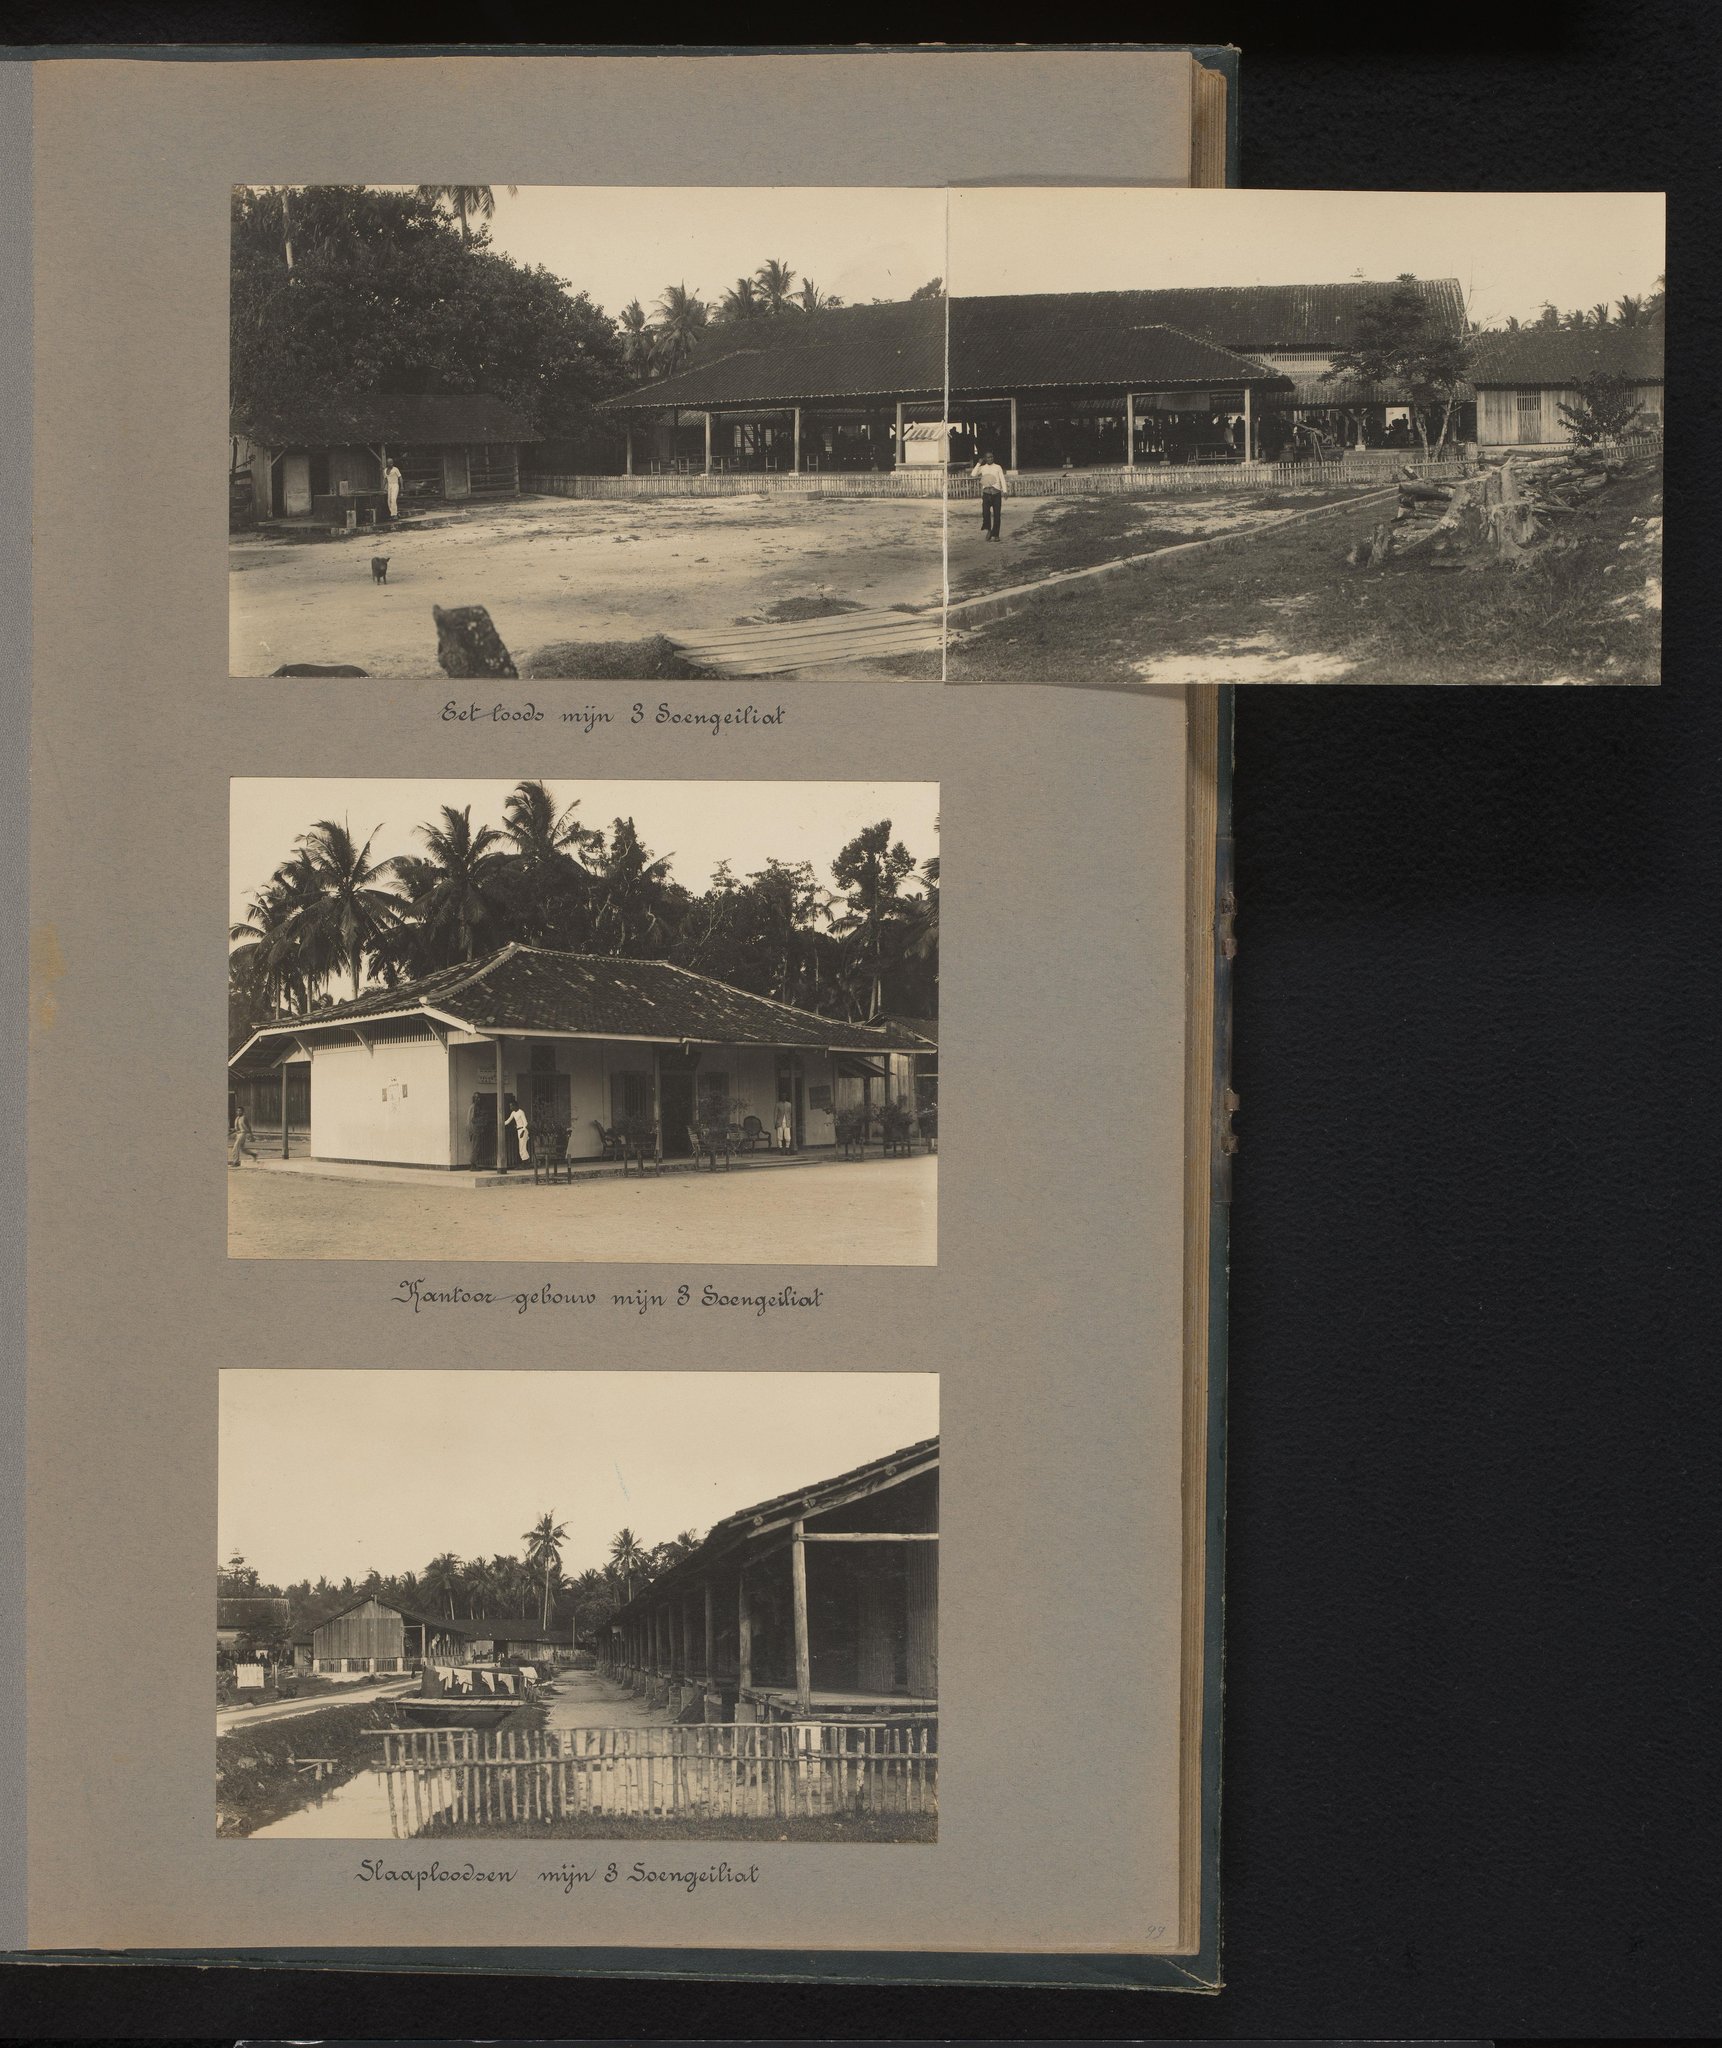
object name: photograph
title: Kantoorgebouw, eet- en slaaploods van de Banka-tinwinning te Soengeiliat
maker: Anonymous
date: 1914-1919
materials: cardboard, photographic support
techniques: gelatin silver print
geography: bangka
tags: robert julius boers, colonial system, mining, working class, labourers, hut, cabin, lodge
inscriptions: inscription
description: Albumblad met 3 foto's van een kantoorgebouw, en een eet- en slaaploods van de Banka-tinwinning te Soengeiliat. Onderdeel van het fotoalbum aangeboden aan Robert Julius Boers bij zijn vertrek naar Nederland in 1919 door het personeel van de Banka-tinwinning.